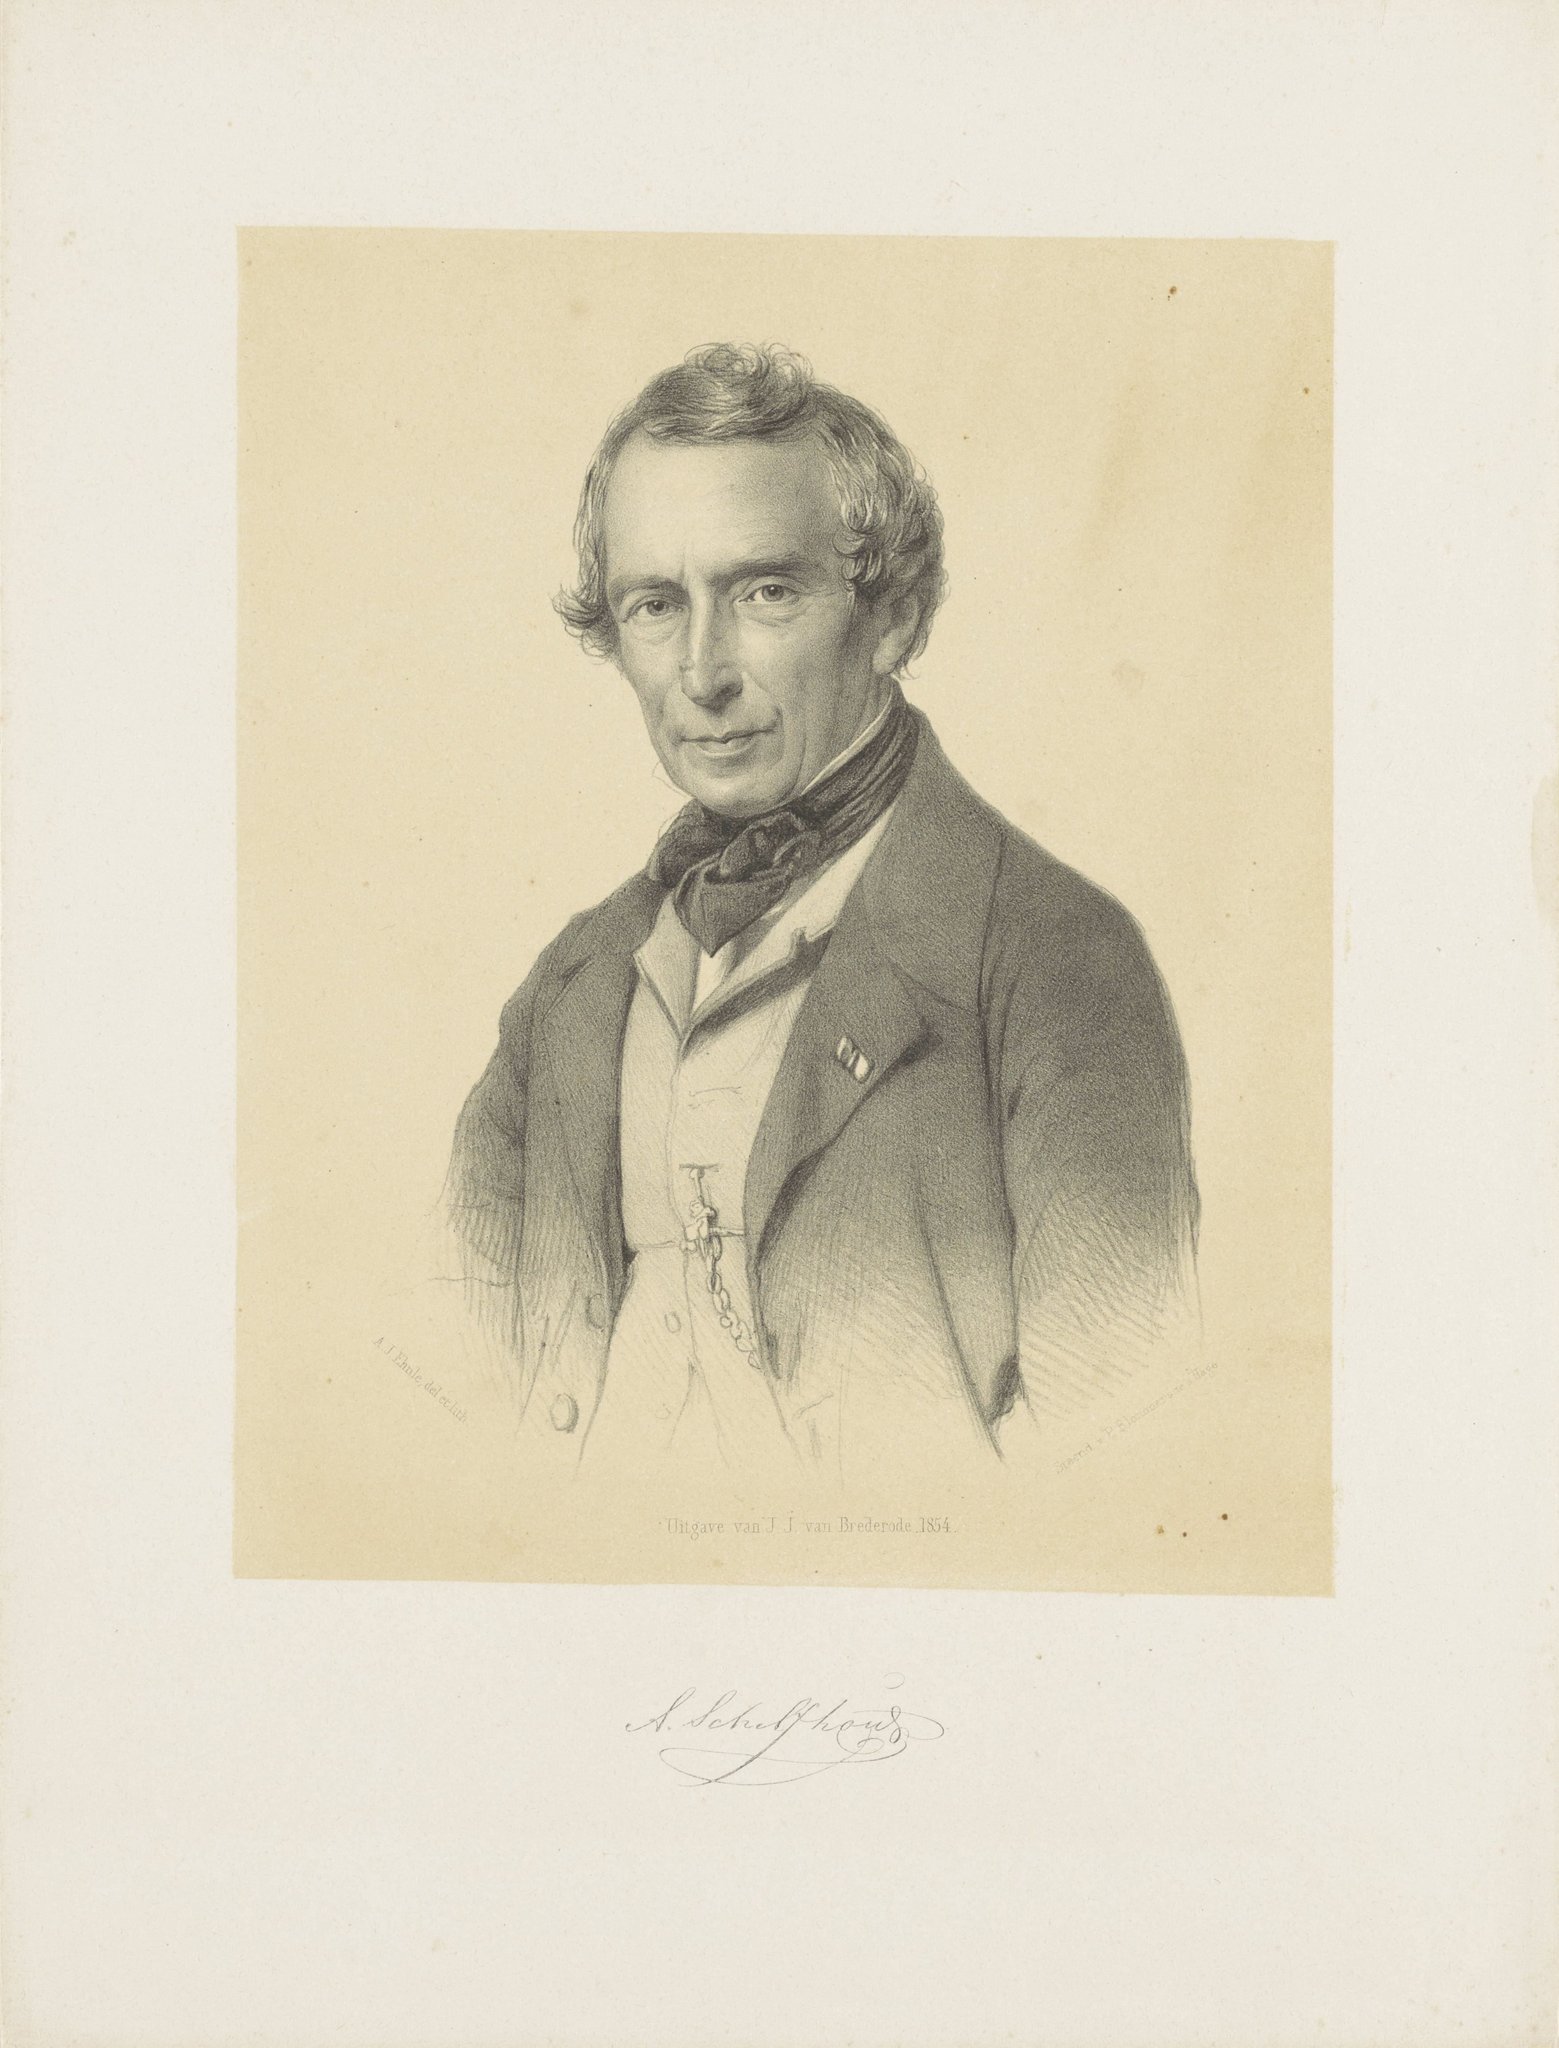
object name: print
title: Portret van Andreas Schelfhout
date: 1854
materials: paper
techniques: tone lithography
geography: the hague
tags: the hague, painter, print maker, draughtsman, andreas schelfhout, knighthood order, historical persons (+ (full) bust portrait)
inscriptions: collector's mark: Lugt 2228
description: De geportretteerde draagt een gestrikte das, een horlogeketting aan zijn vest en een ridderorde op de revers van zijn jas. Onder het portret zijn signatuur.